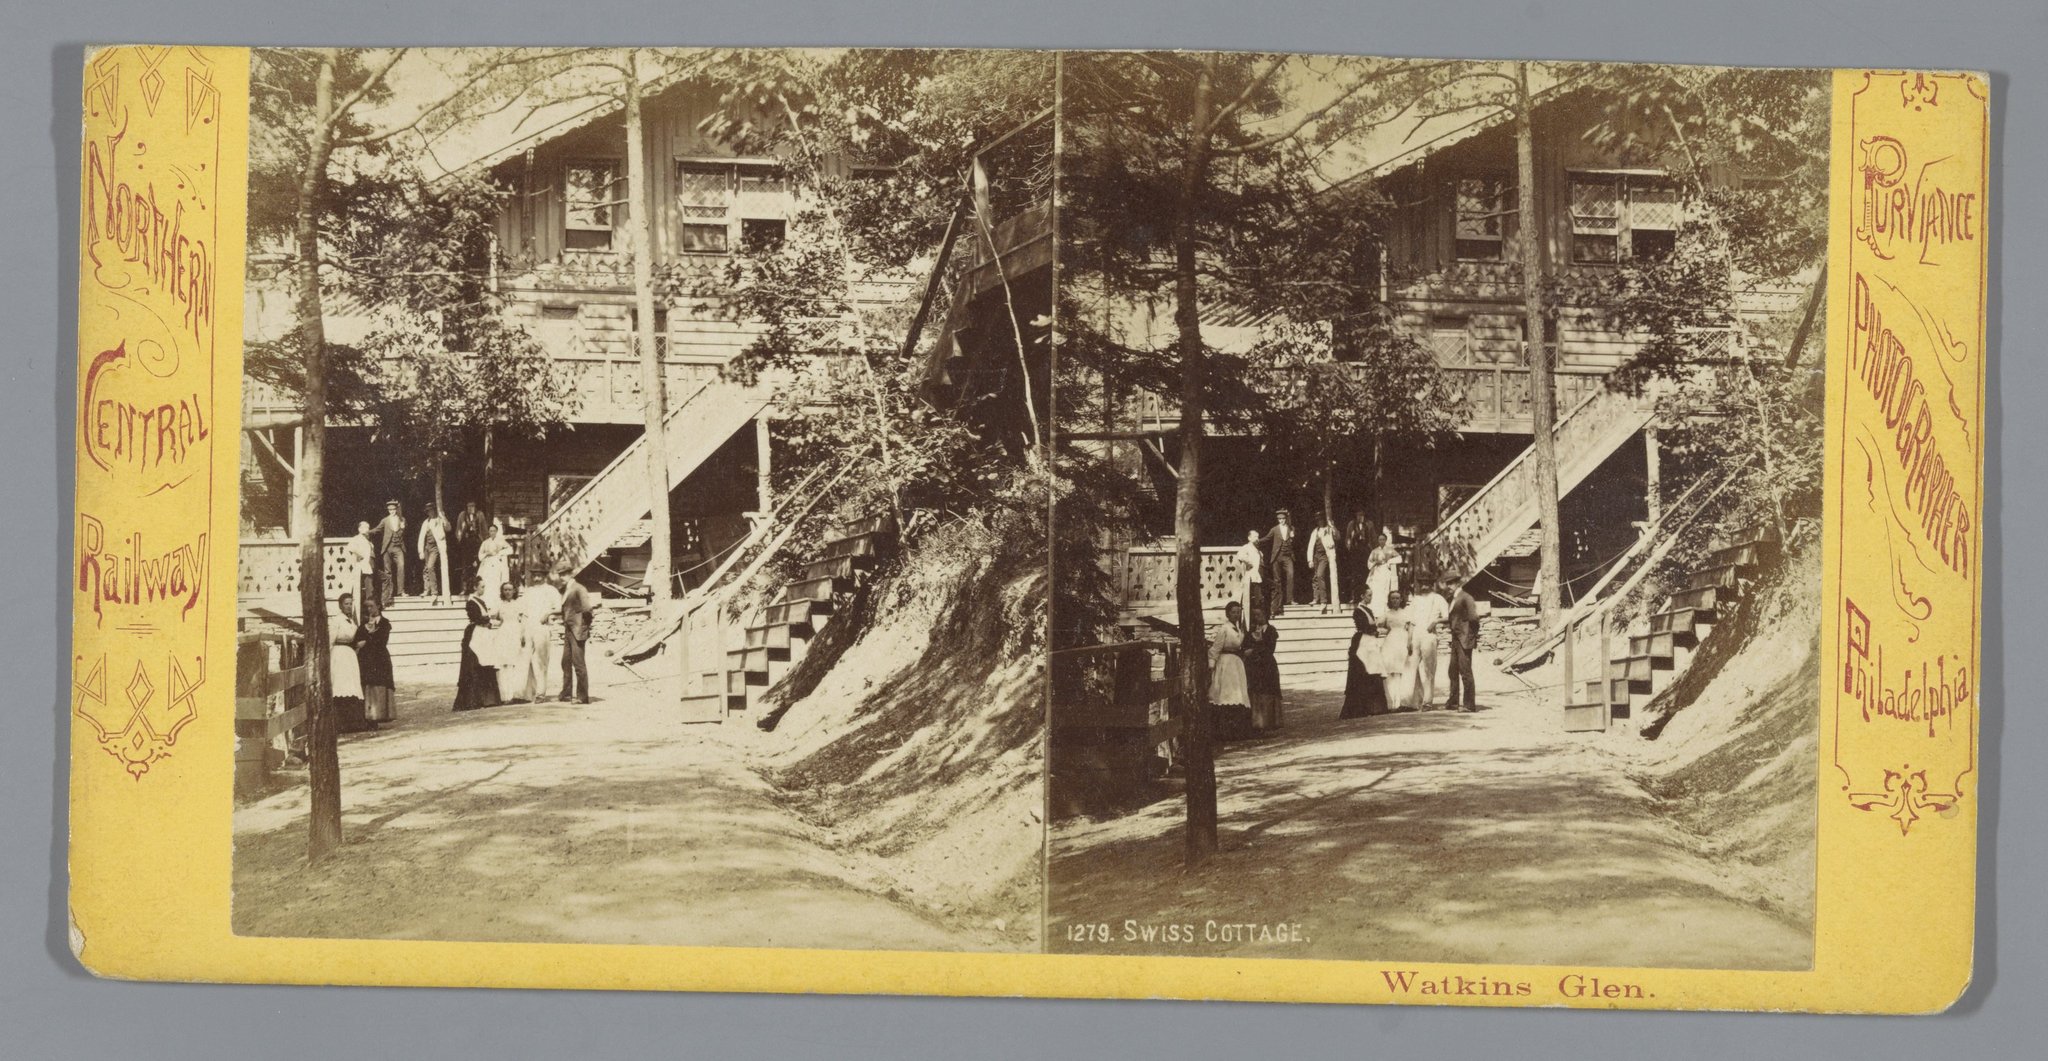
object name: stereograph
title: Swiss Cottage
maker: william t. purviance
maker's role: publisher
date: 1860-1880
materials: cardboard, paper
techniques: albumen print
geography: watkins glen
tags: cottage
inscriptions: number: ‘1279’, title: ‘Swiss Cottage’